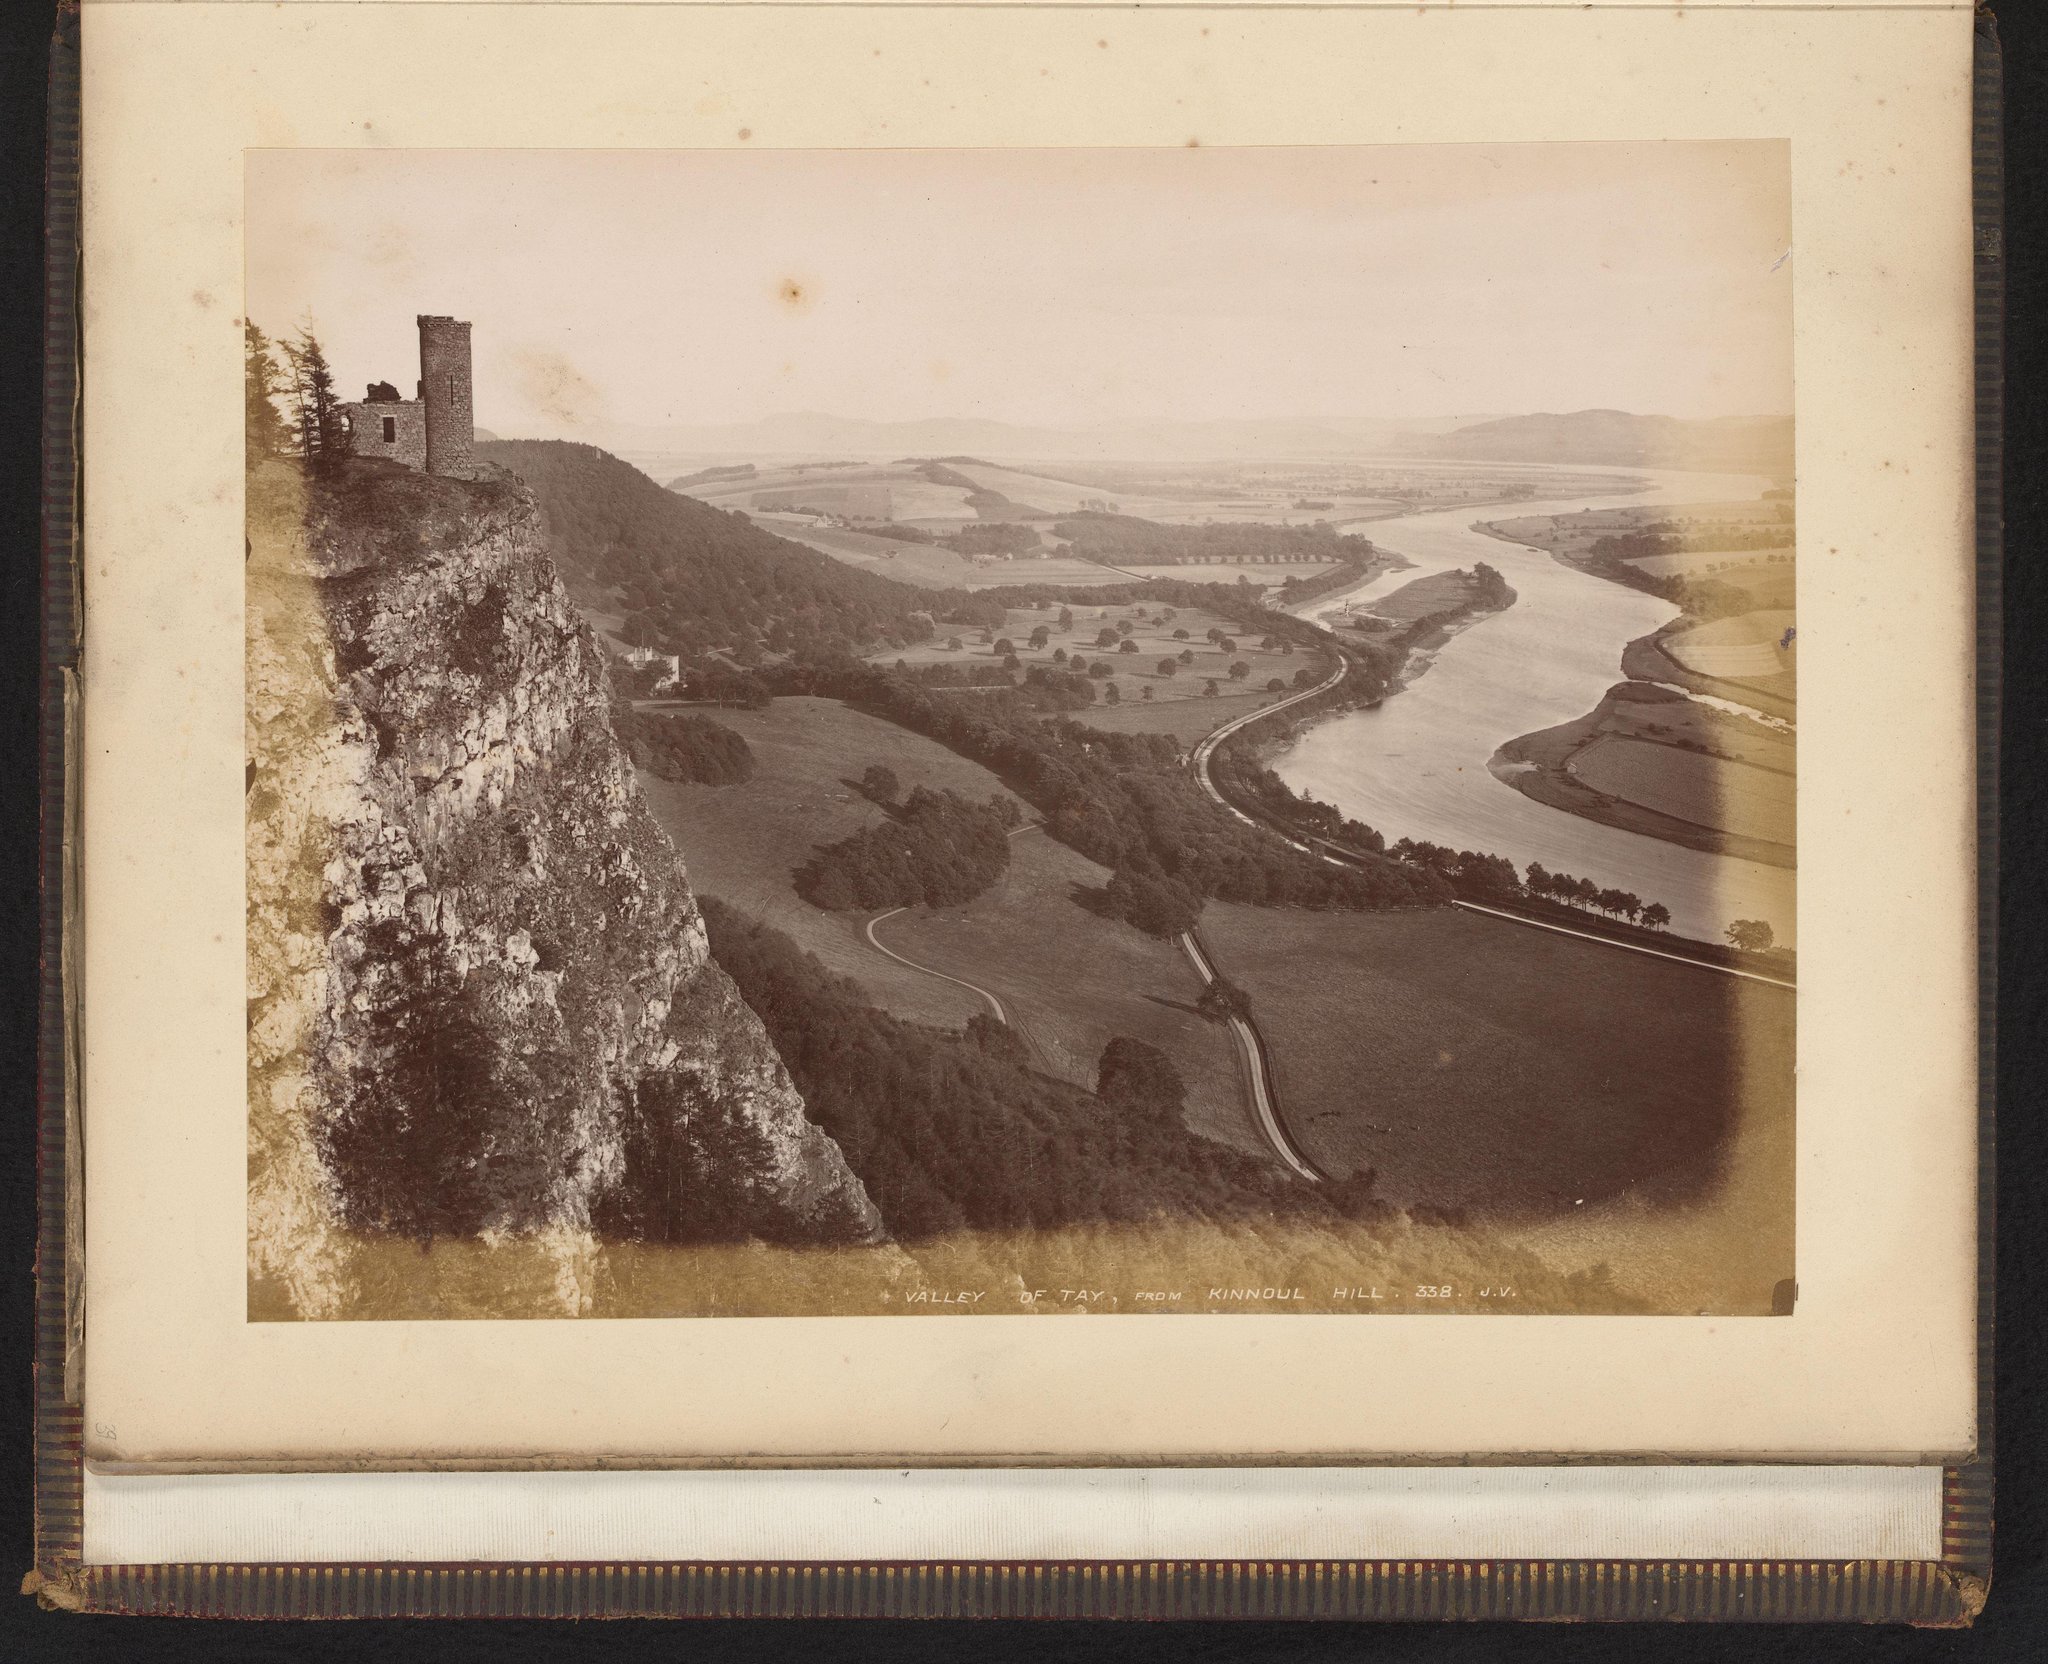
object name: photograph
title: Valley of Tay, from Kinnoul Hill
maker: Anonymous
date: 1875-1885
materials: photographic support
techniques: albumen print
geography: kinnoull hill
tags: dale, valley, river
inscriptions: number: ‘338, J.V.’